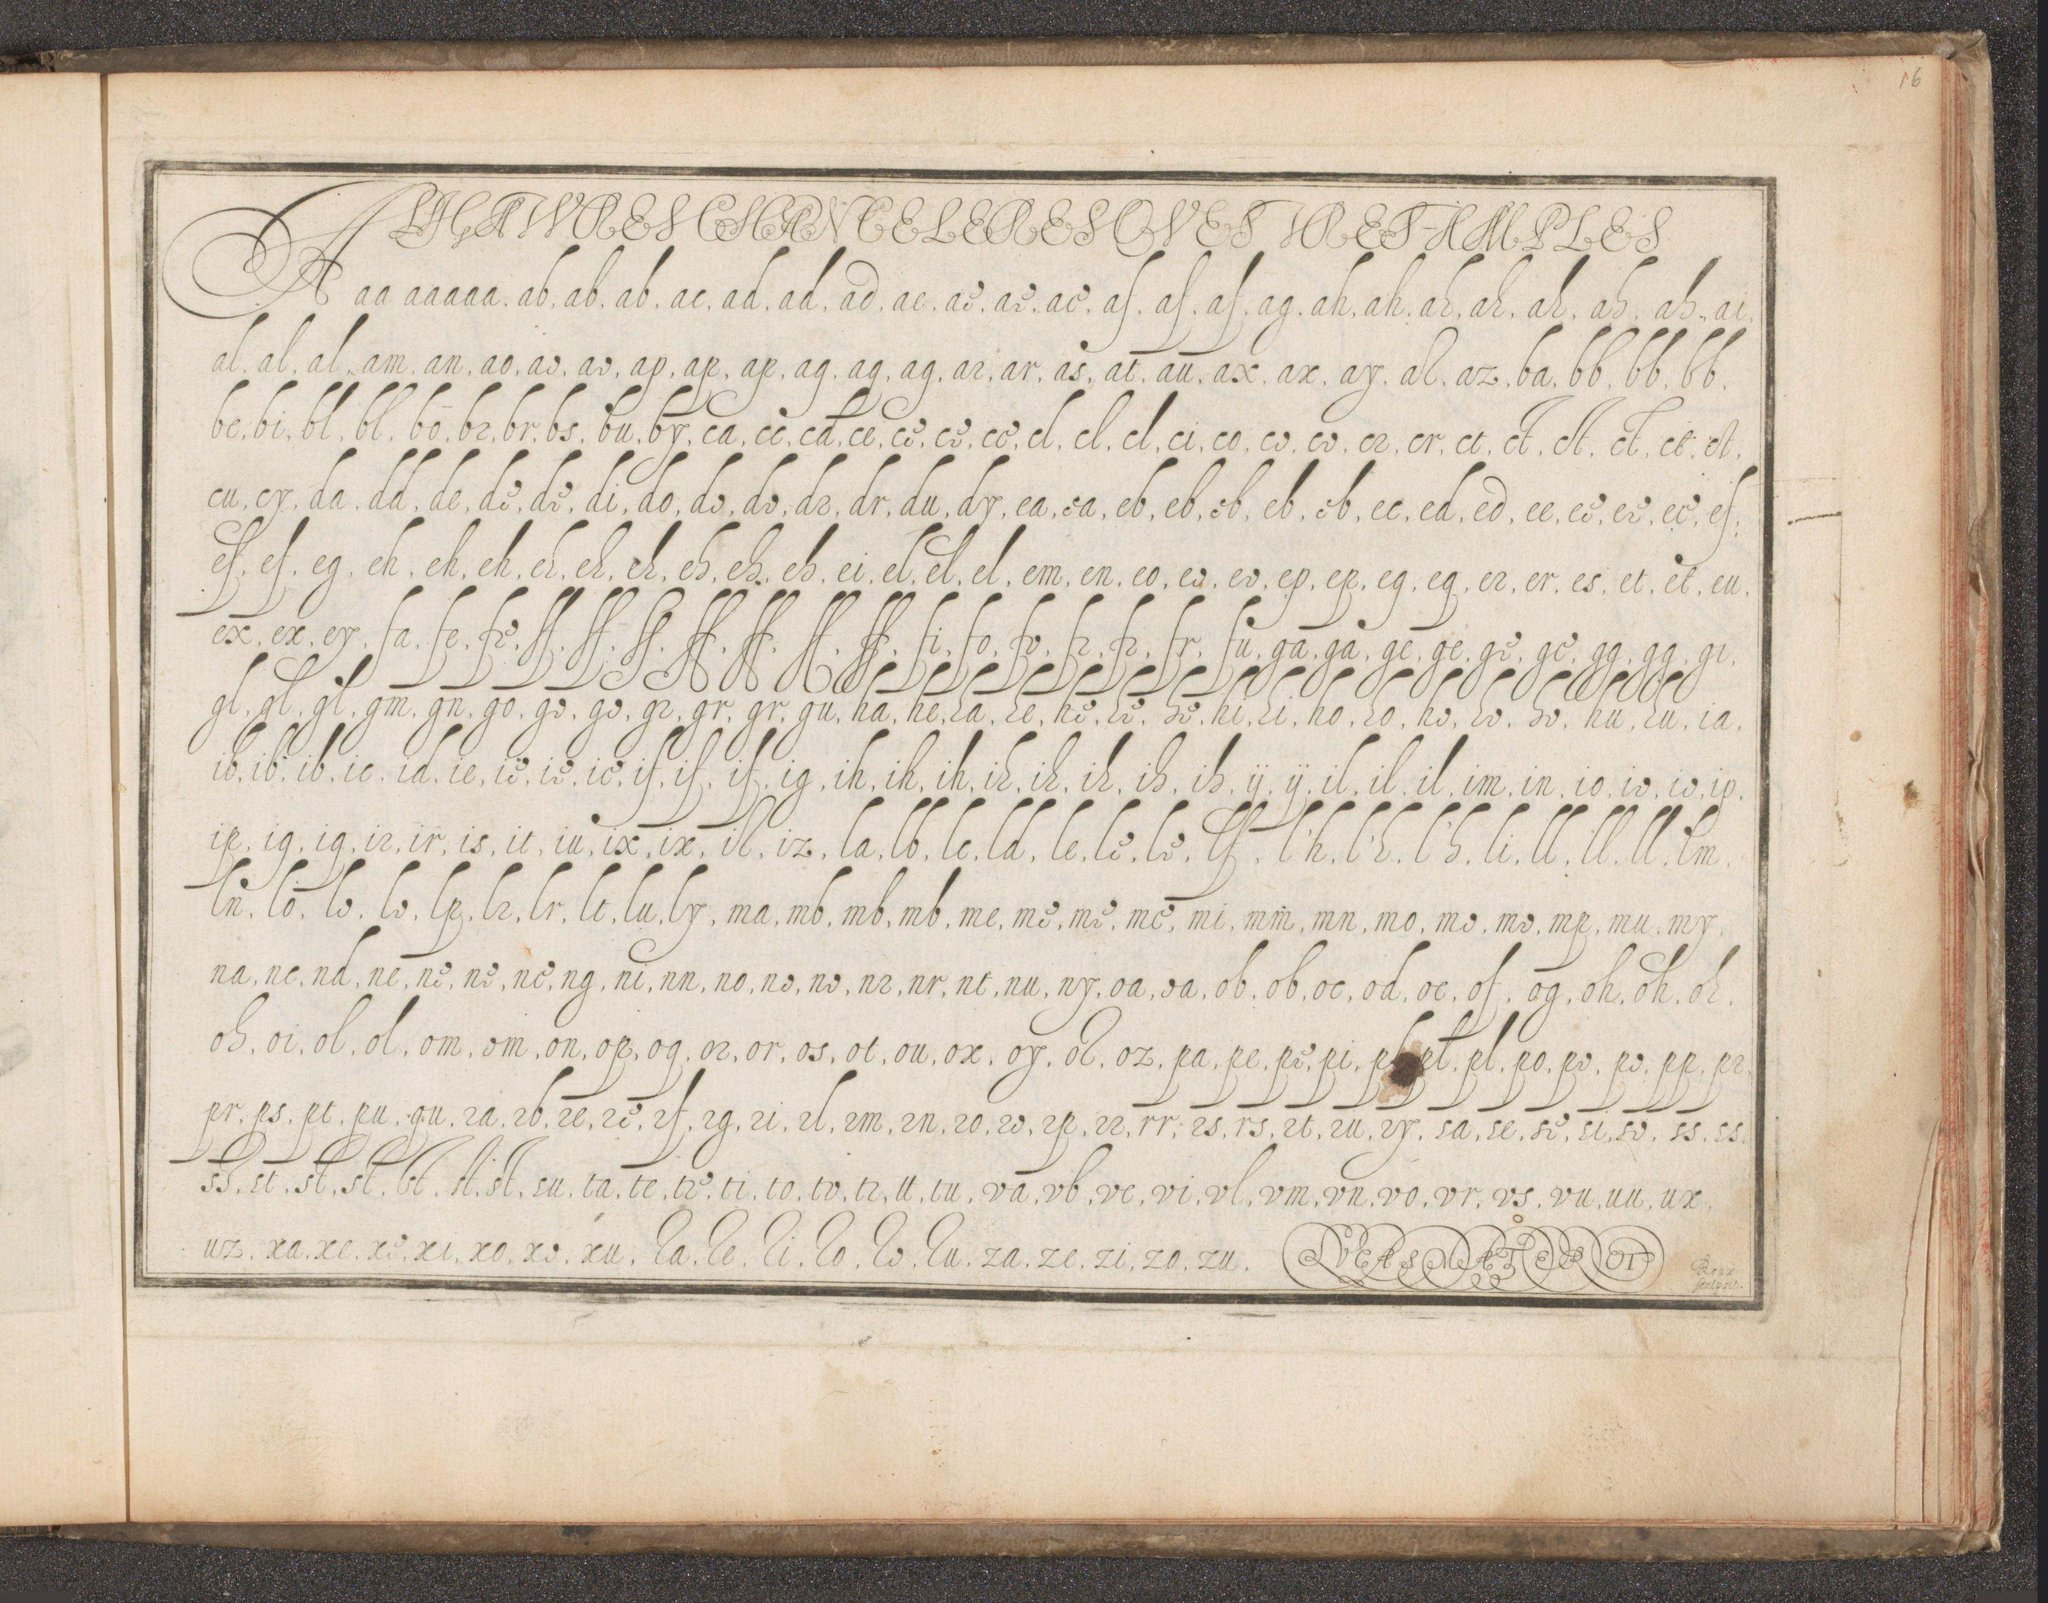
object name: album leaf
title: Les Oeuvres [(...)] Ou l'on comprendre facilement la manier de bien et proprement escrire toute sorte de lettre Italienne selon l'usage de ce siècle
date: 1608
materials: paper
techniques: engraving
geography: avignon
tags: calligraphy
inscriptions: signature and date: ‘Op titelblad: Judoco Hondio celatore. Amstelodami apud Joannem Janssonium. 1614’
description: Schrijfvoorbeeld in een humanistische hand met aanhef en zes regels tekst in het Frans. De tekst is omlijst door krulwerk. De prent maakt deel uit van een album.